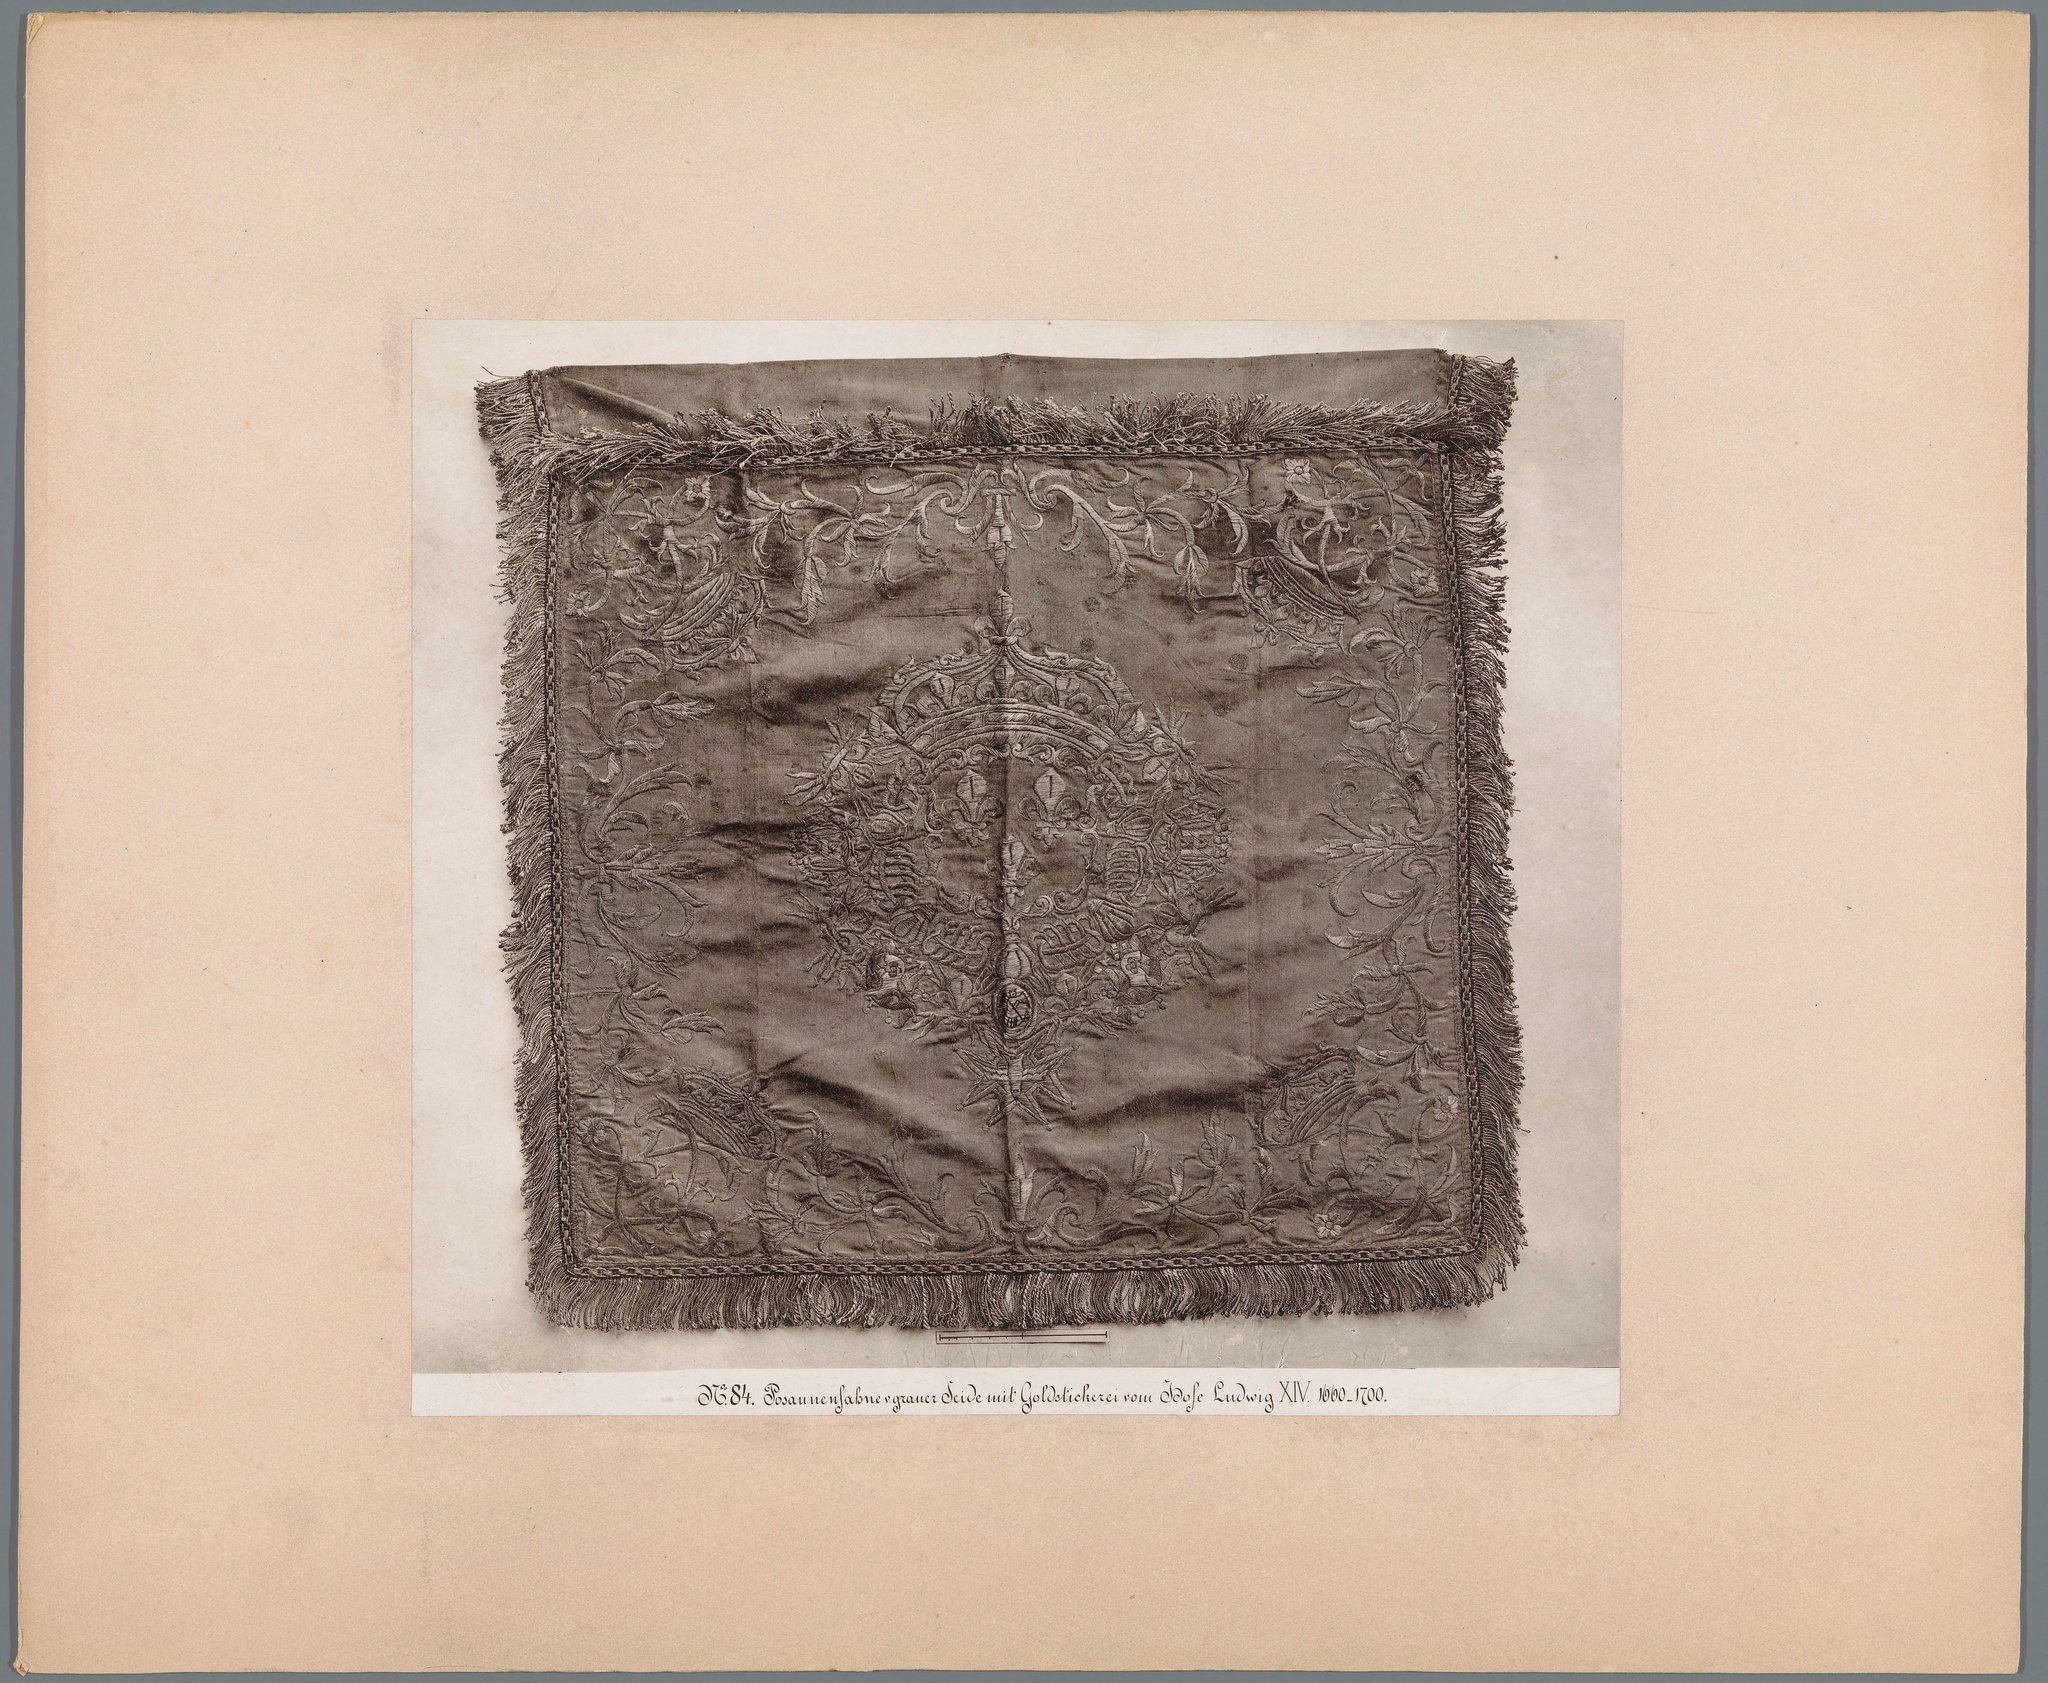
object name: photograph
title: Posaunenfahne v. grauer Seide mit Goldstickerei vom Hofe Ludwig XIV. 1660-1700.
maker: Anonymous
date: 1875-1900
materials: cardboard, paper, ink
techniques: photograph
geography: europe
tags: fleur-de-lis ~ ornament, textile fabric, cloth, europe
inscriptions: inscription: ‘[...] National-Museum’, collector's mark: Lugt 3937, number: ‘No. 84.’